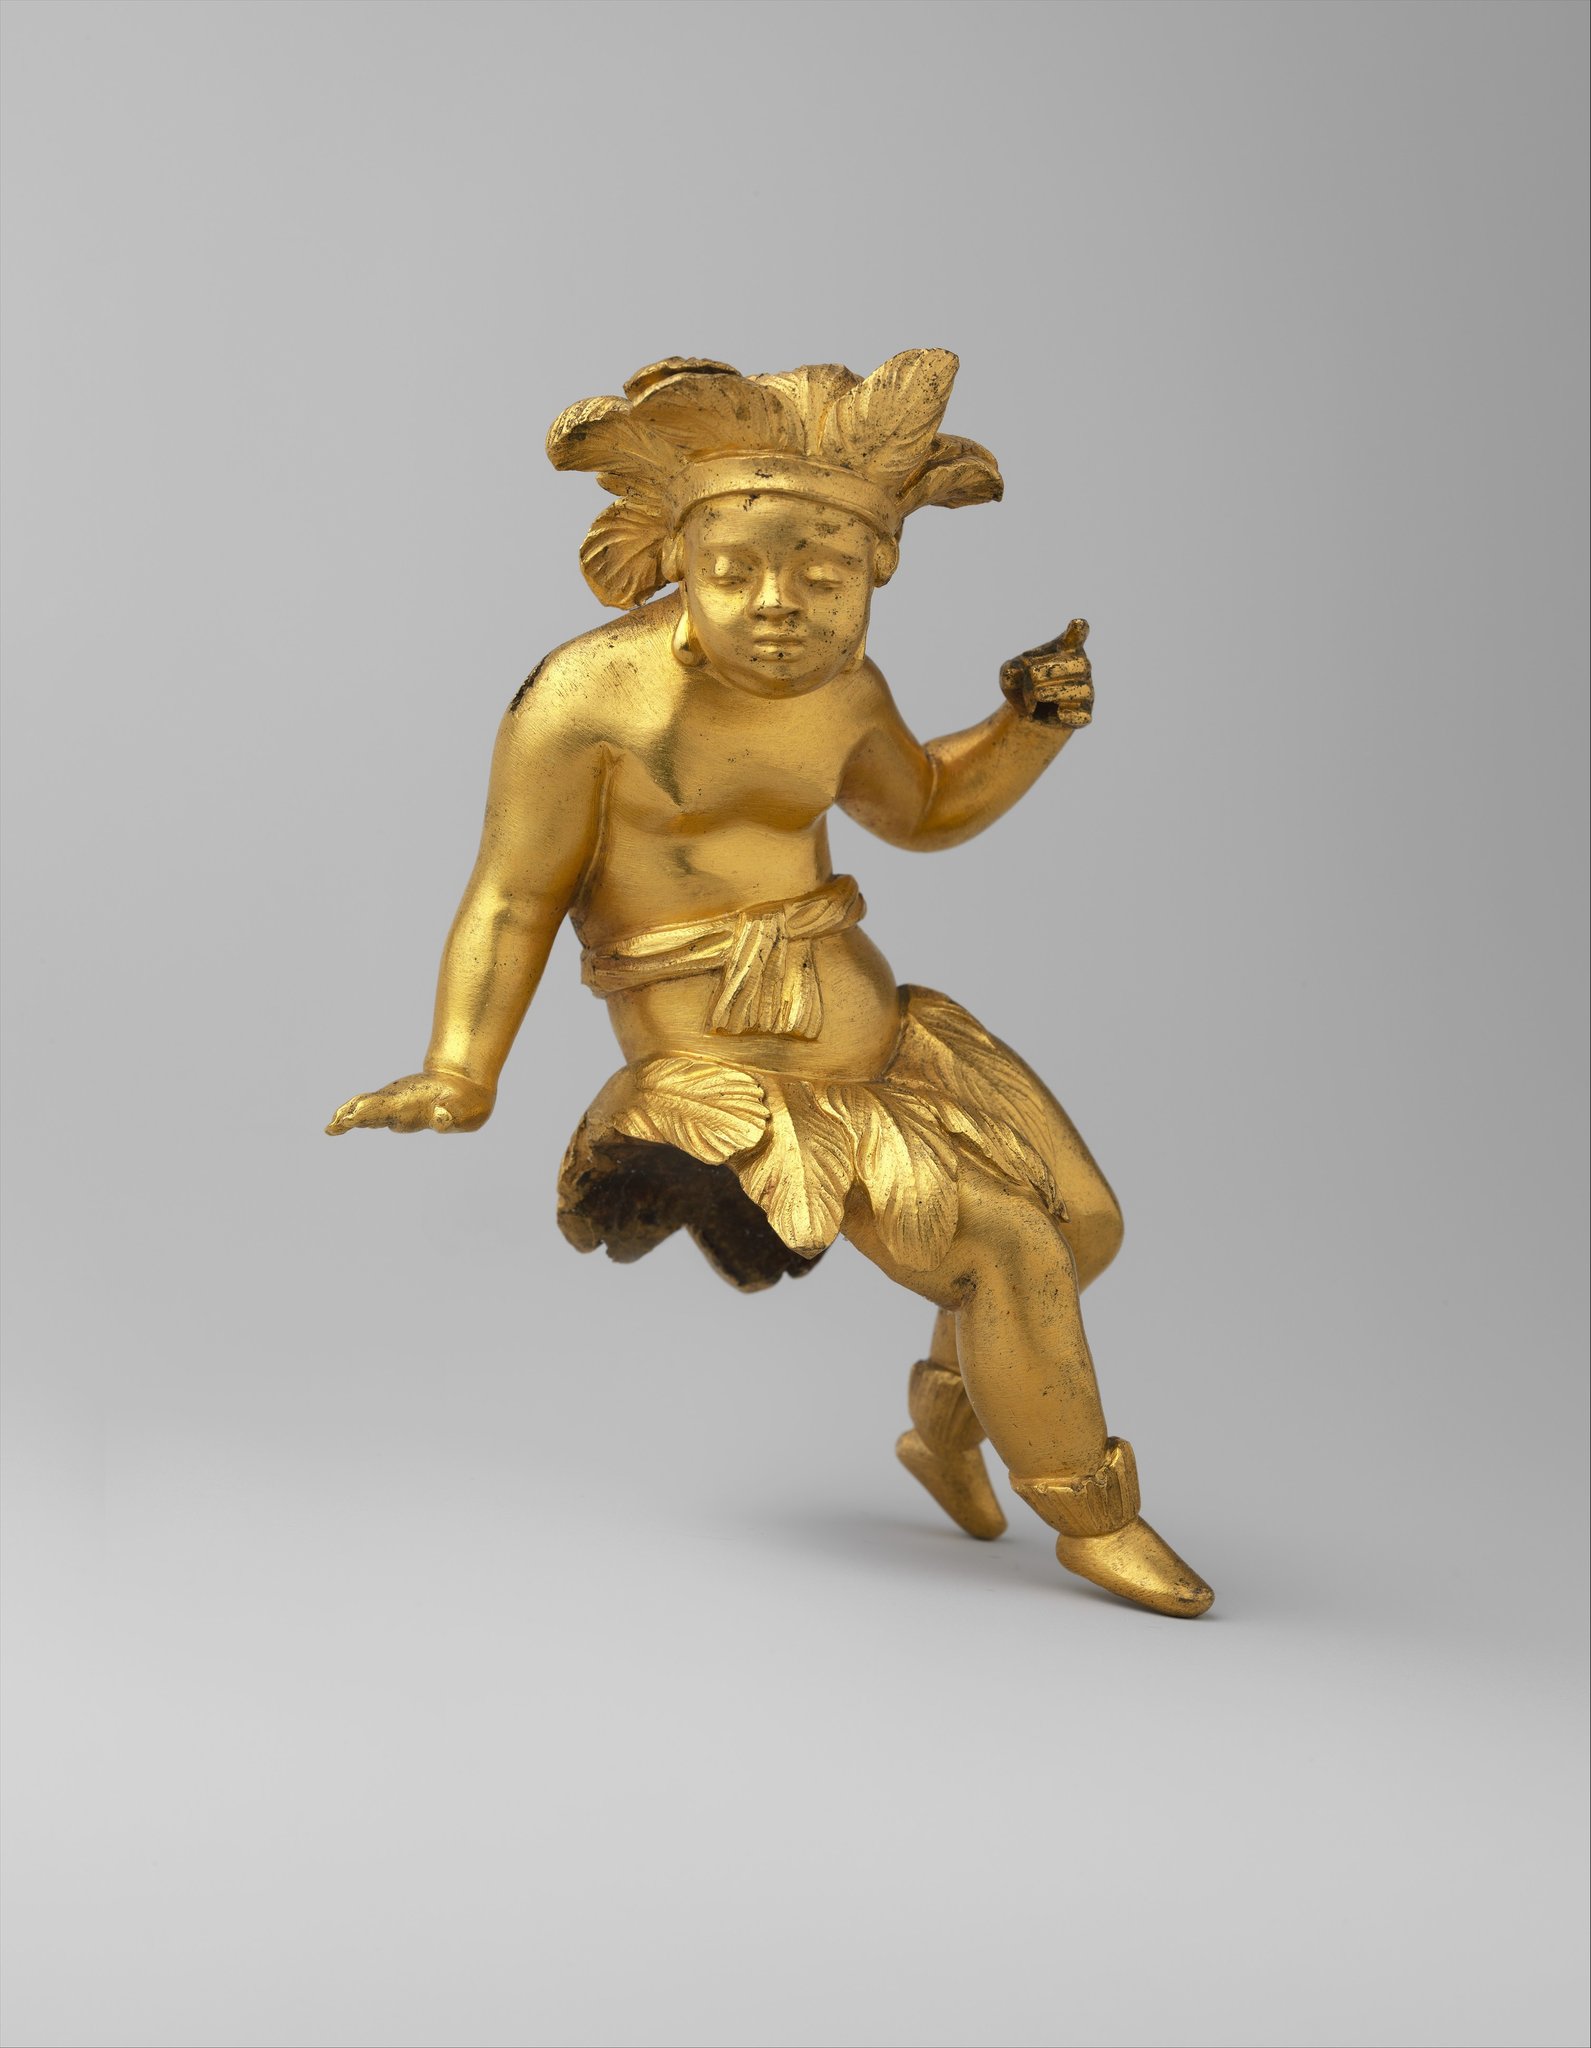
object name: clock ornament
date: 1726-1750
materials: gilt bronze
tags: boys